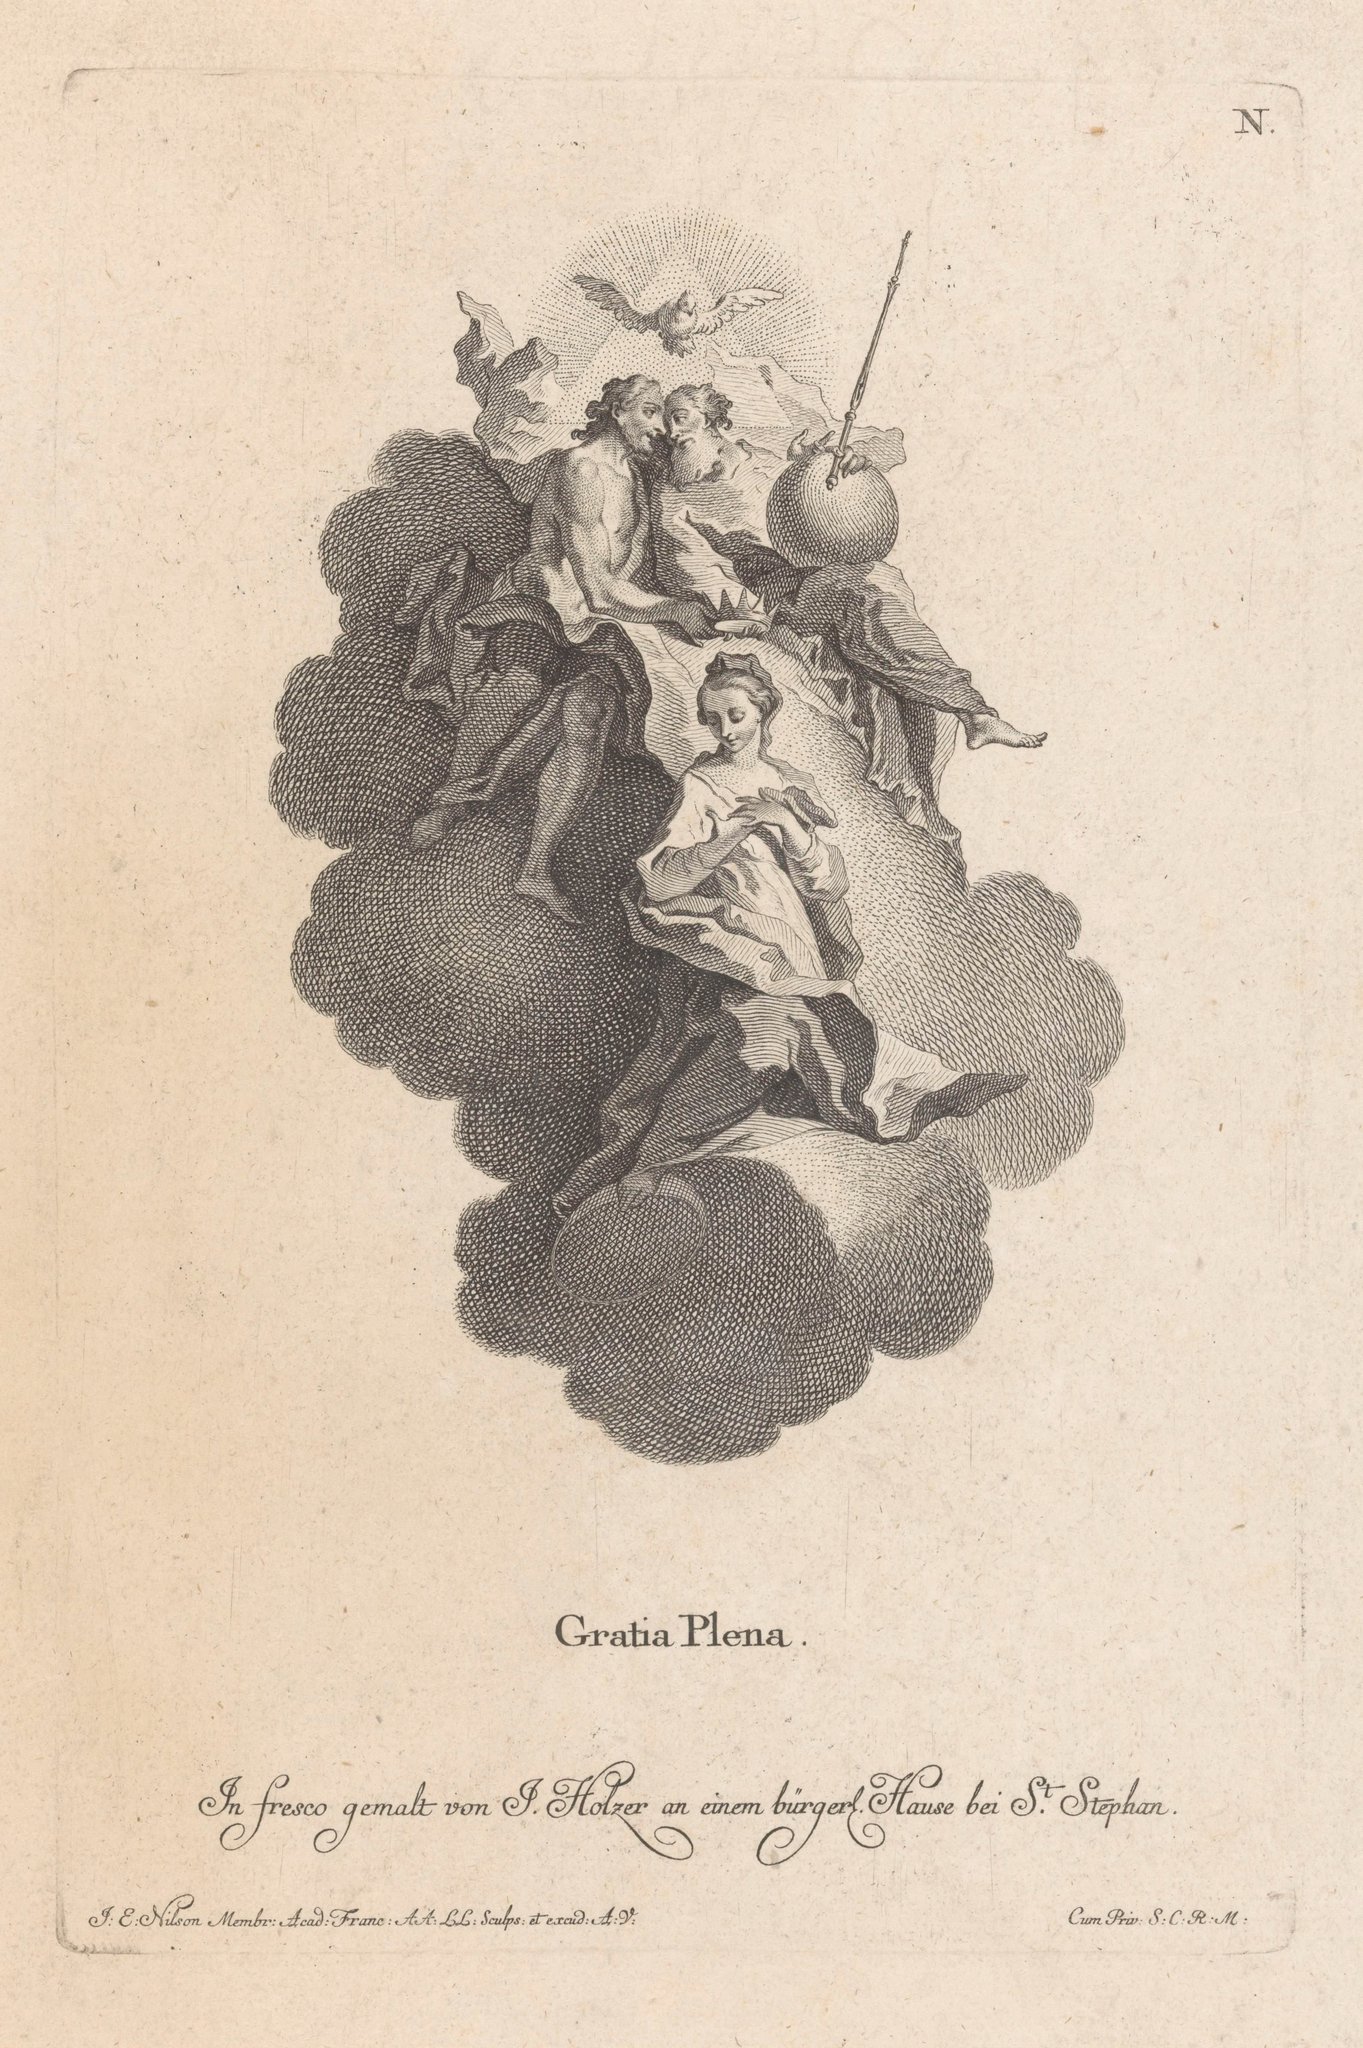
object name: print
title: Picturae a Fresco in Aedibus Augustae Vindelic (...)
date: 1765-1770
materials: paper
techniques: engraving, etching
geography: augsburg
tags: trinity in which god the father and christ are represented as persons, the holy ghost as dove, coronation of mary by god the father and christ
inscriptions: collector's mark: Lugt 2228, collector's mark: Lugt 2760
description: De kroning van Maria door Christus en God de Vader met globe en scepter. De duif als symbool van de Heilige Geest vormt tezamen met Christus en God de Heilige Drie-eenheid.